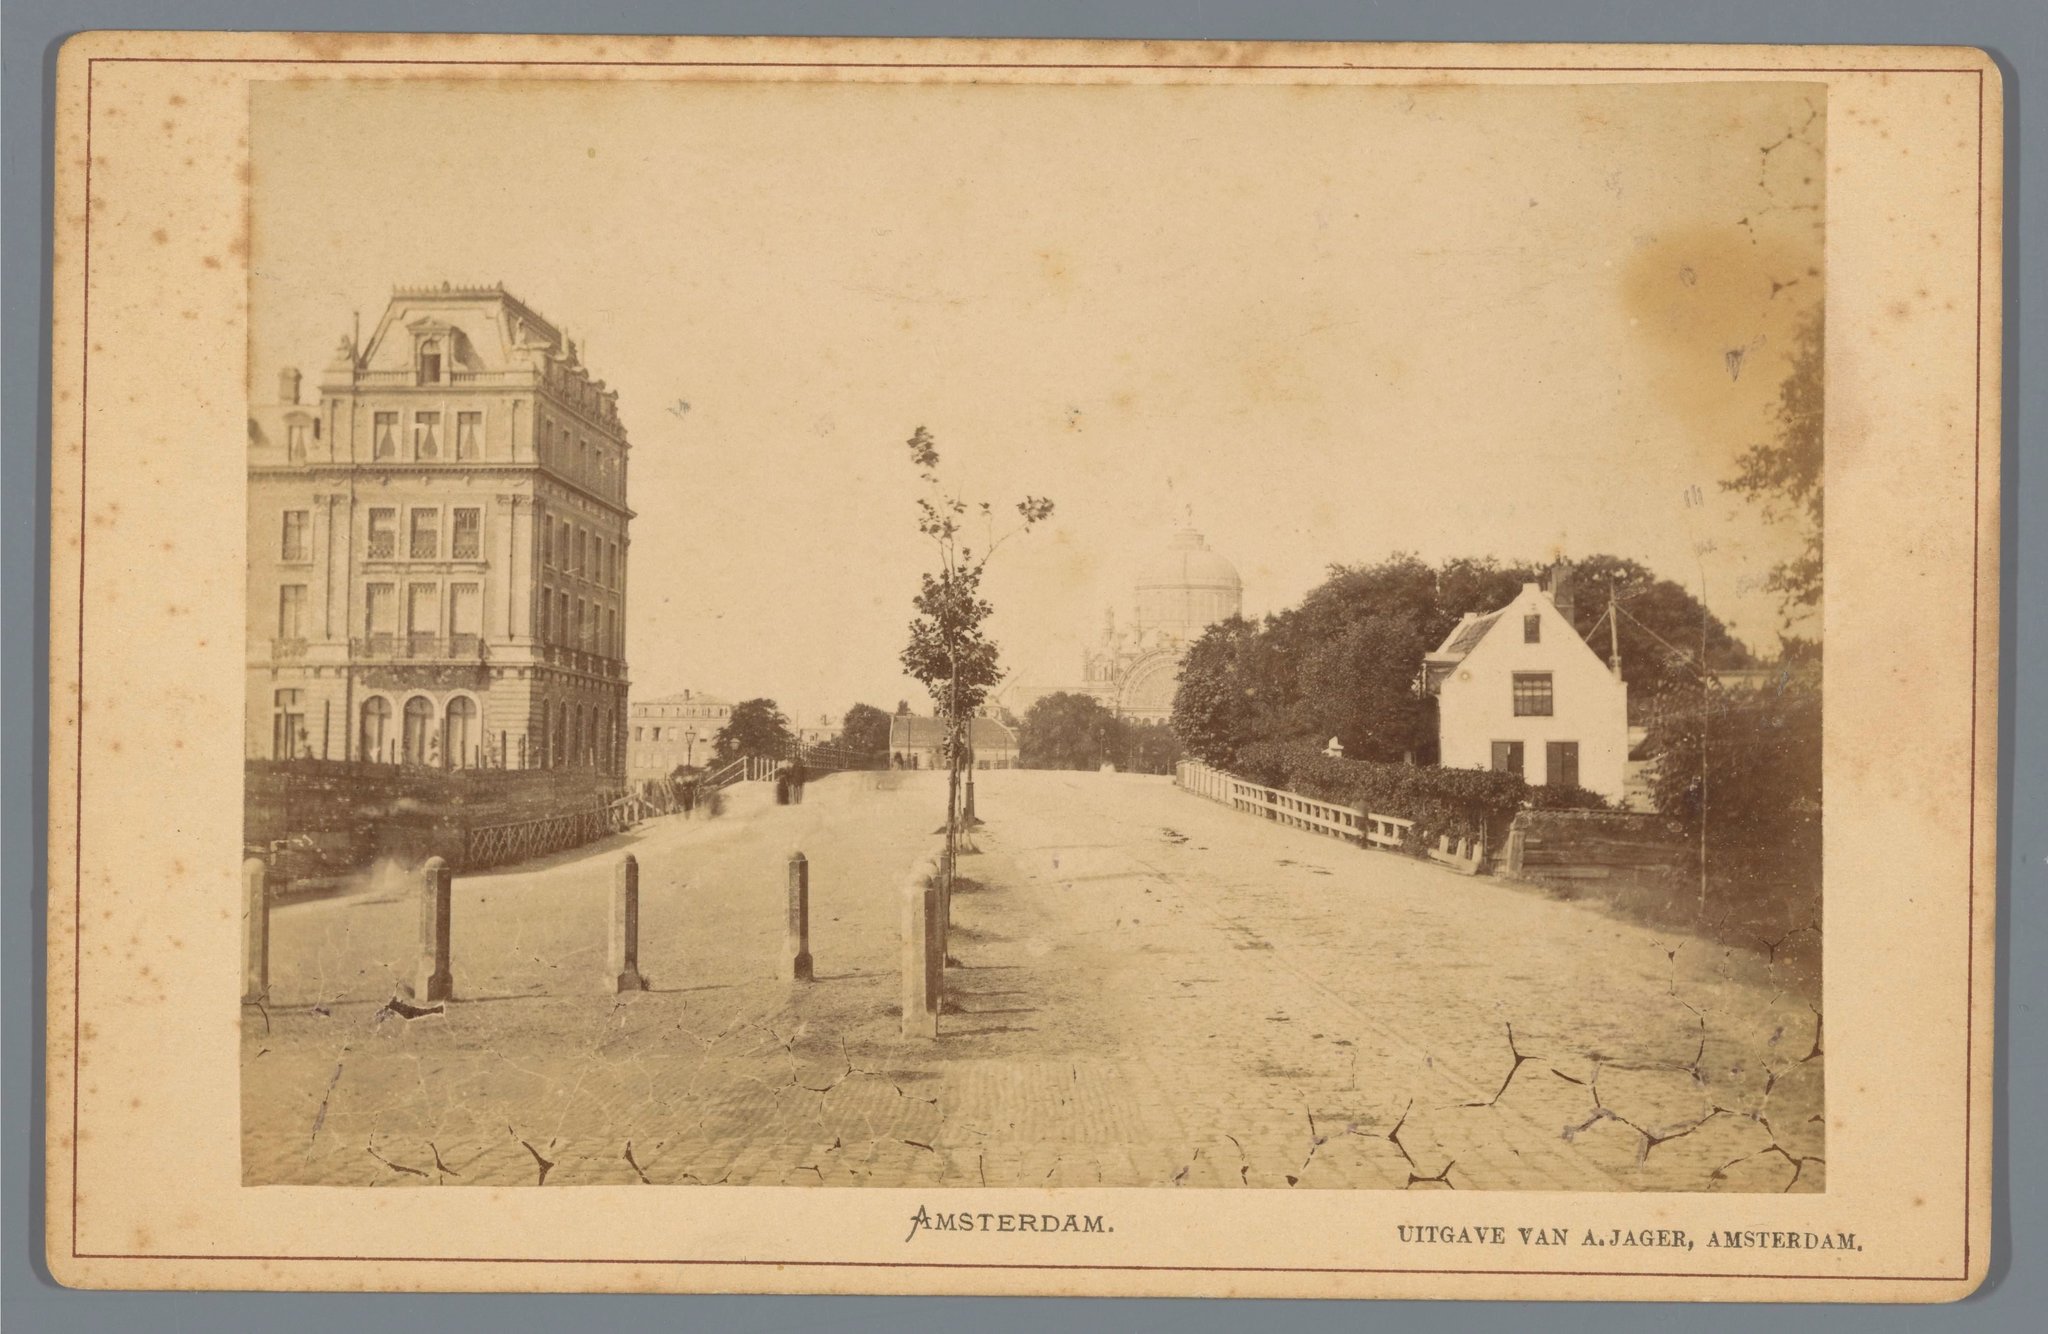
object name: cabinet photograph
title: Amsterdam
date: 1860-1890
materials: cardboard, photographic support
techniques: albumen print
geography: amsterdam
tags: bridge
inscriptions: annotation: ‘52 kaarten’, annotation: ‘de voormalige Hoogesluis met’